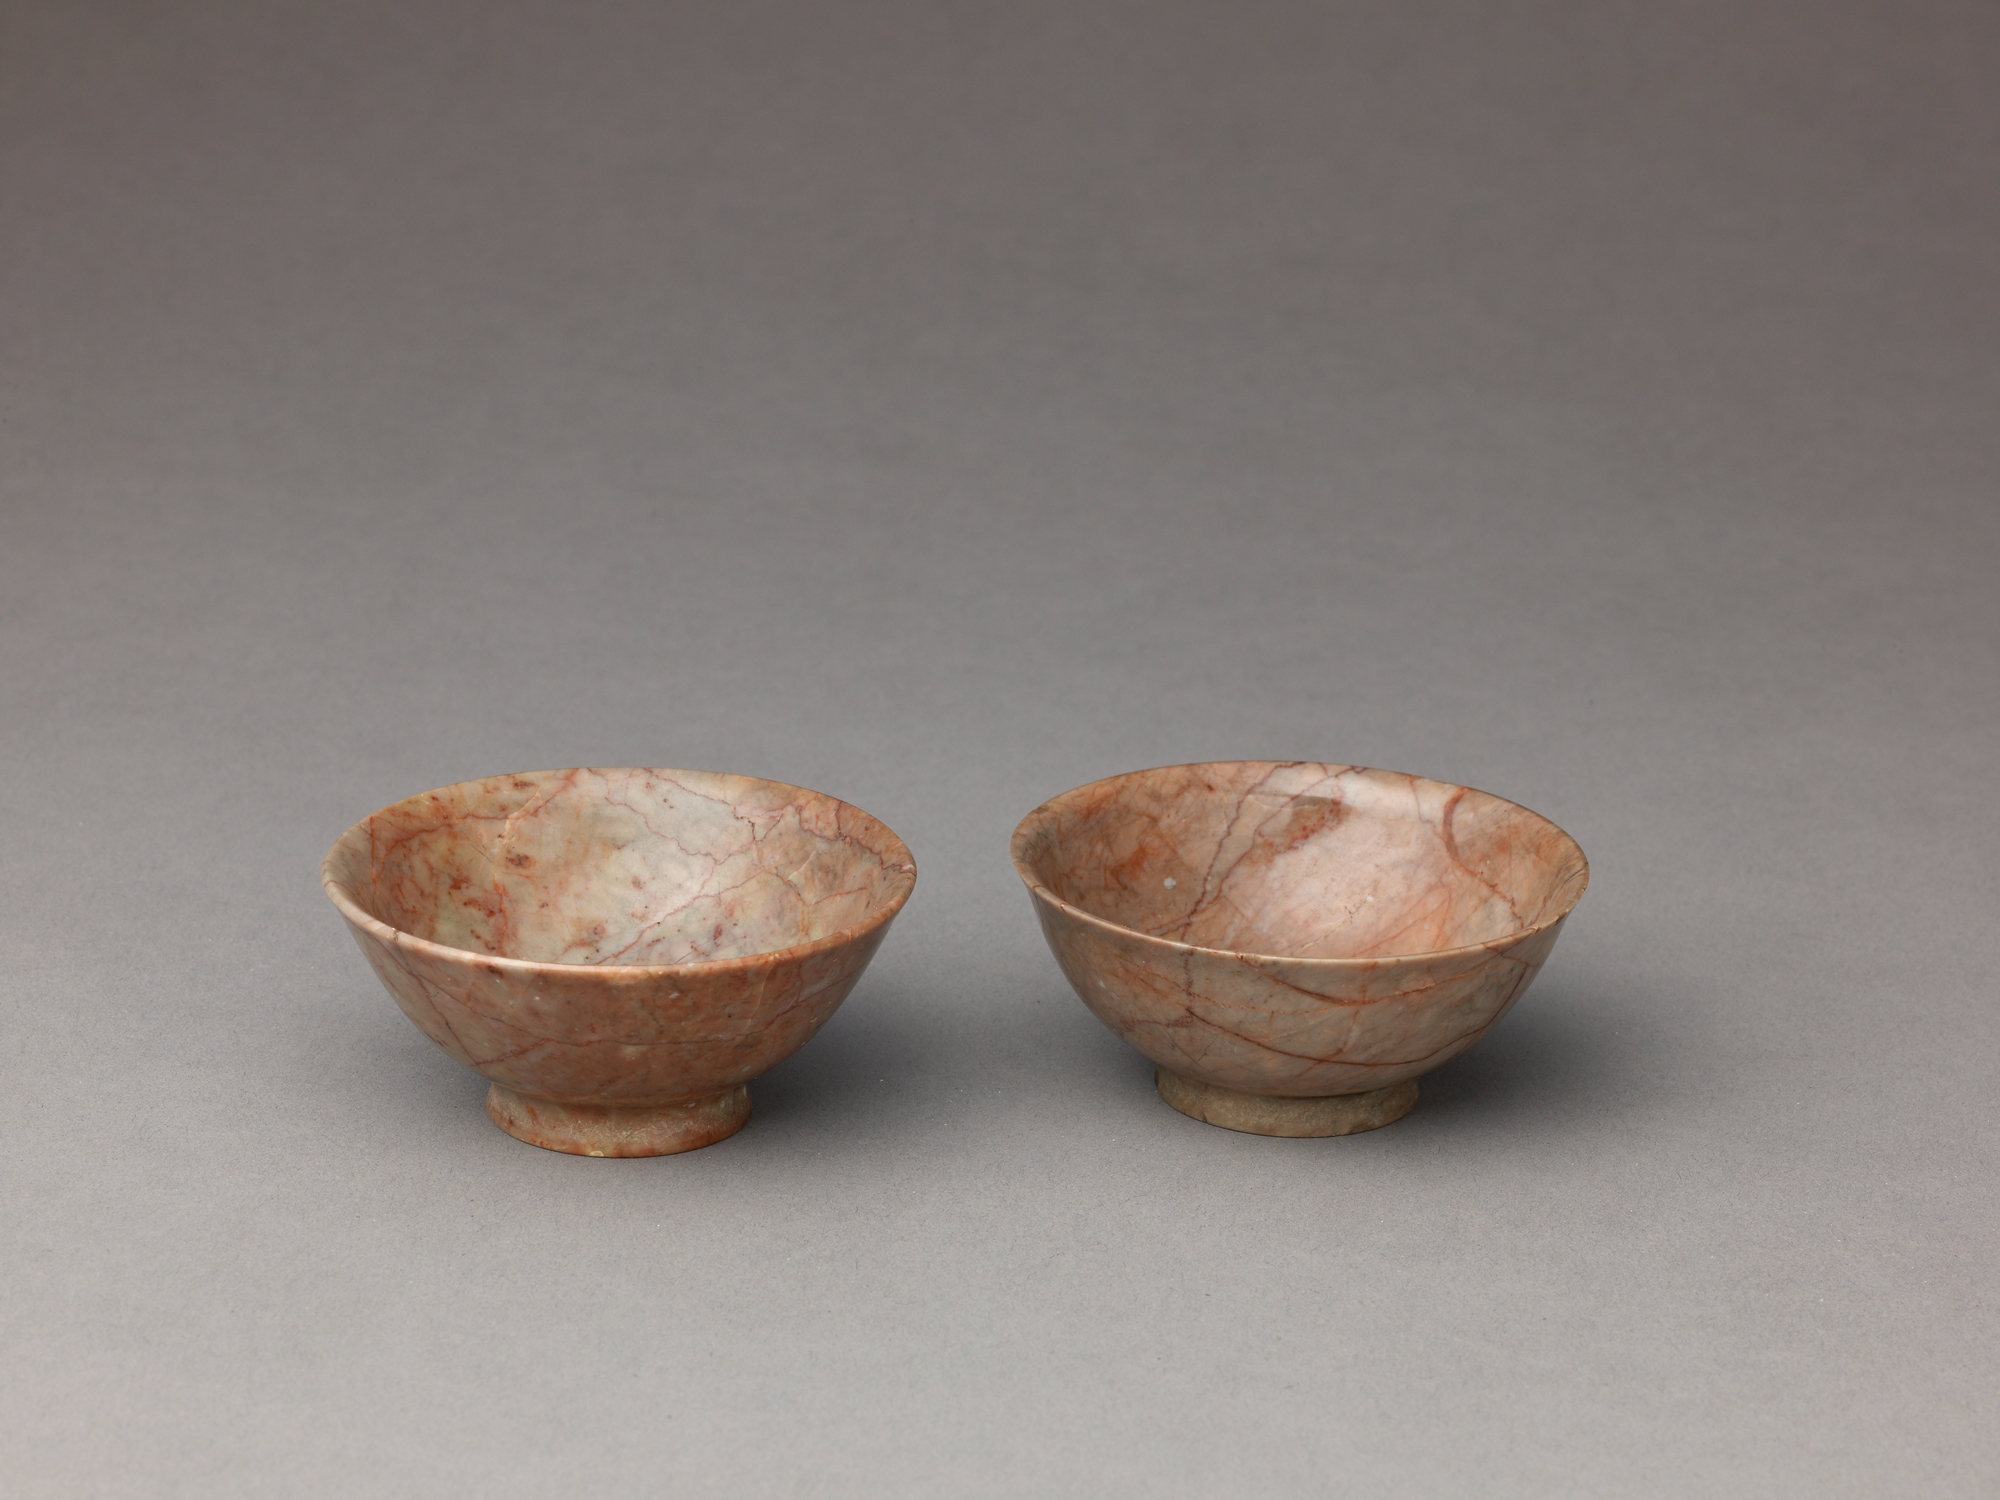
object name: bowl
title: Bowl (see also 1975.1.1751)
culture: chinese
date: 1801-1900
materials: limestone